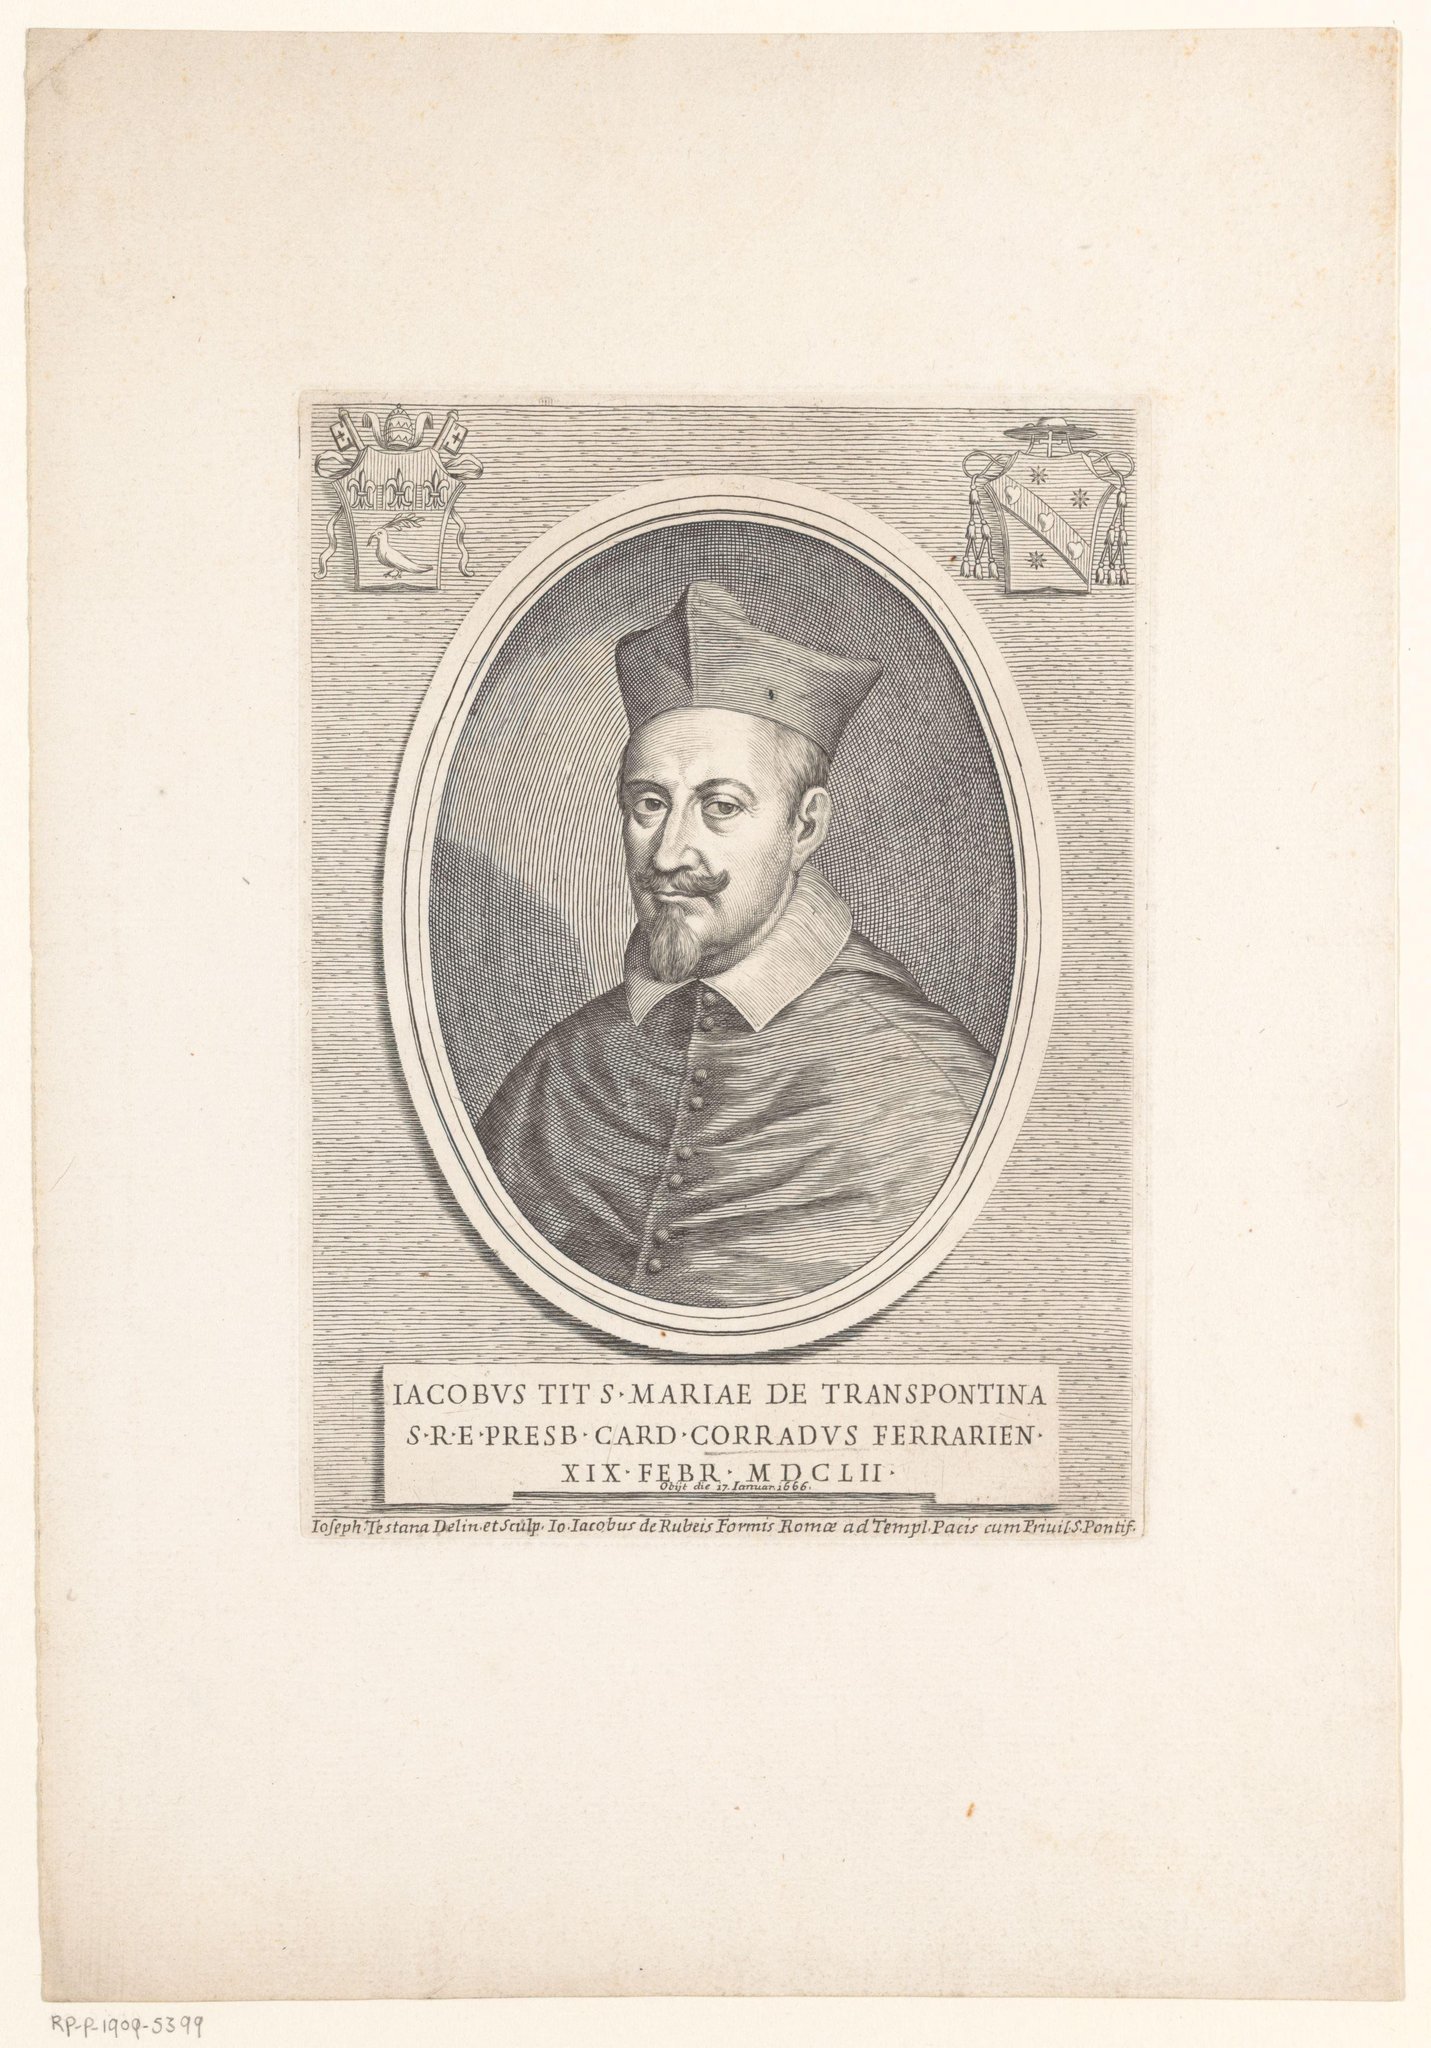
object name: print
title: Effigies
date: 1658-1679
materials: paper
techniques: engraving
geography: italy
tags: cardinal, historical persons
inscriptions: collector's mark: Lugt 2228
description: Prent uit een reeks van onbekende omvang met portretten van kardinalen. De prenten werden vanaf 1657 vervaardigd in opdracht van uitgever Giovanni Giacomo de’ Rossi, waarna de productie werd voortgezet onder leiding van zijn opvolgers Domenico de’ Rossi en Lorenzo Filippo de’ Rossi, en ten slotte onder leiding van de Calcographia R.C.A.